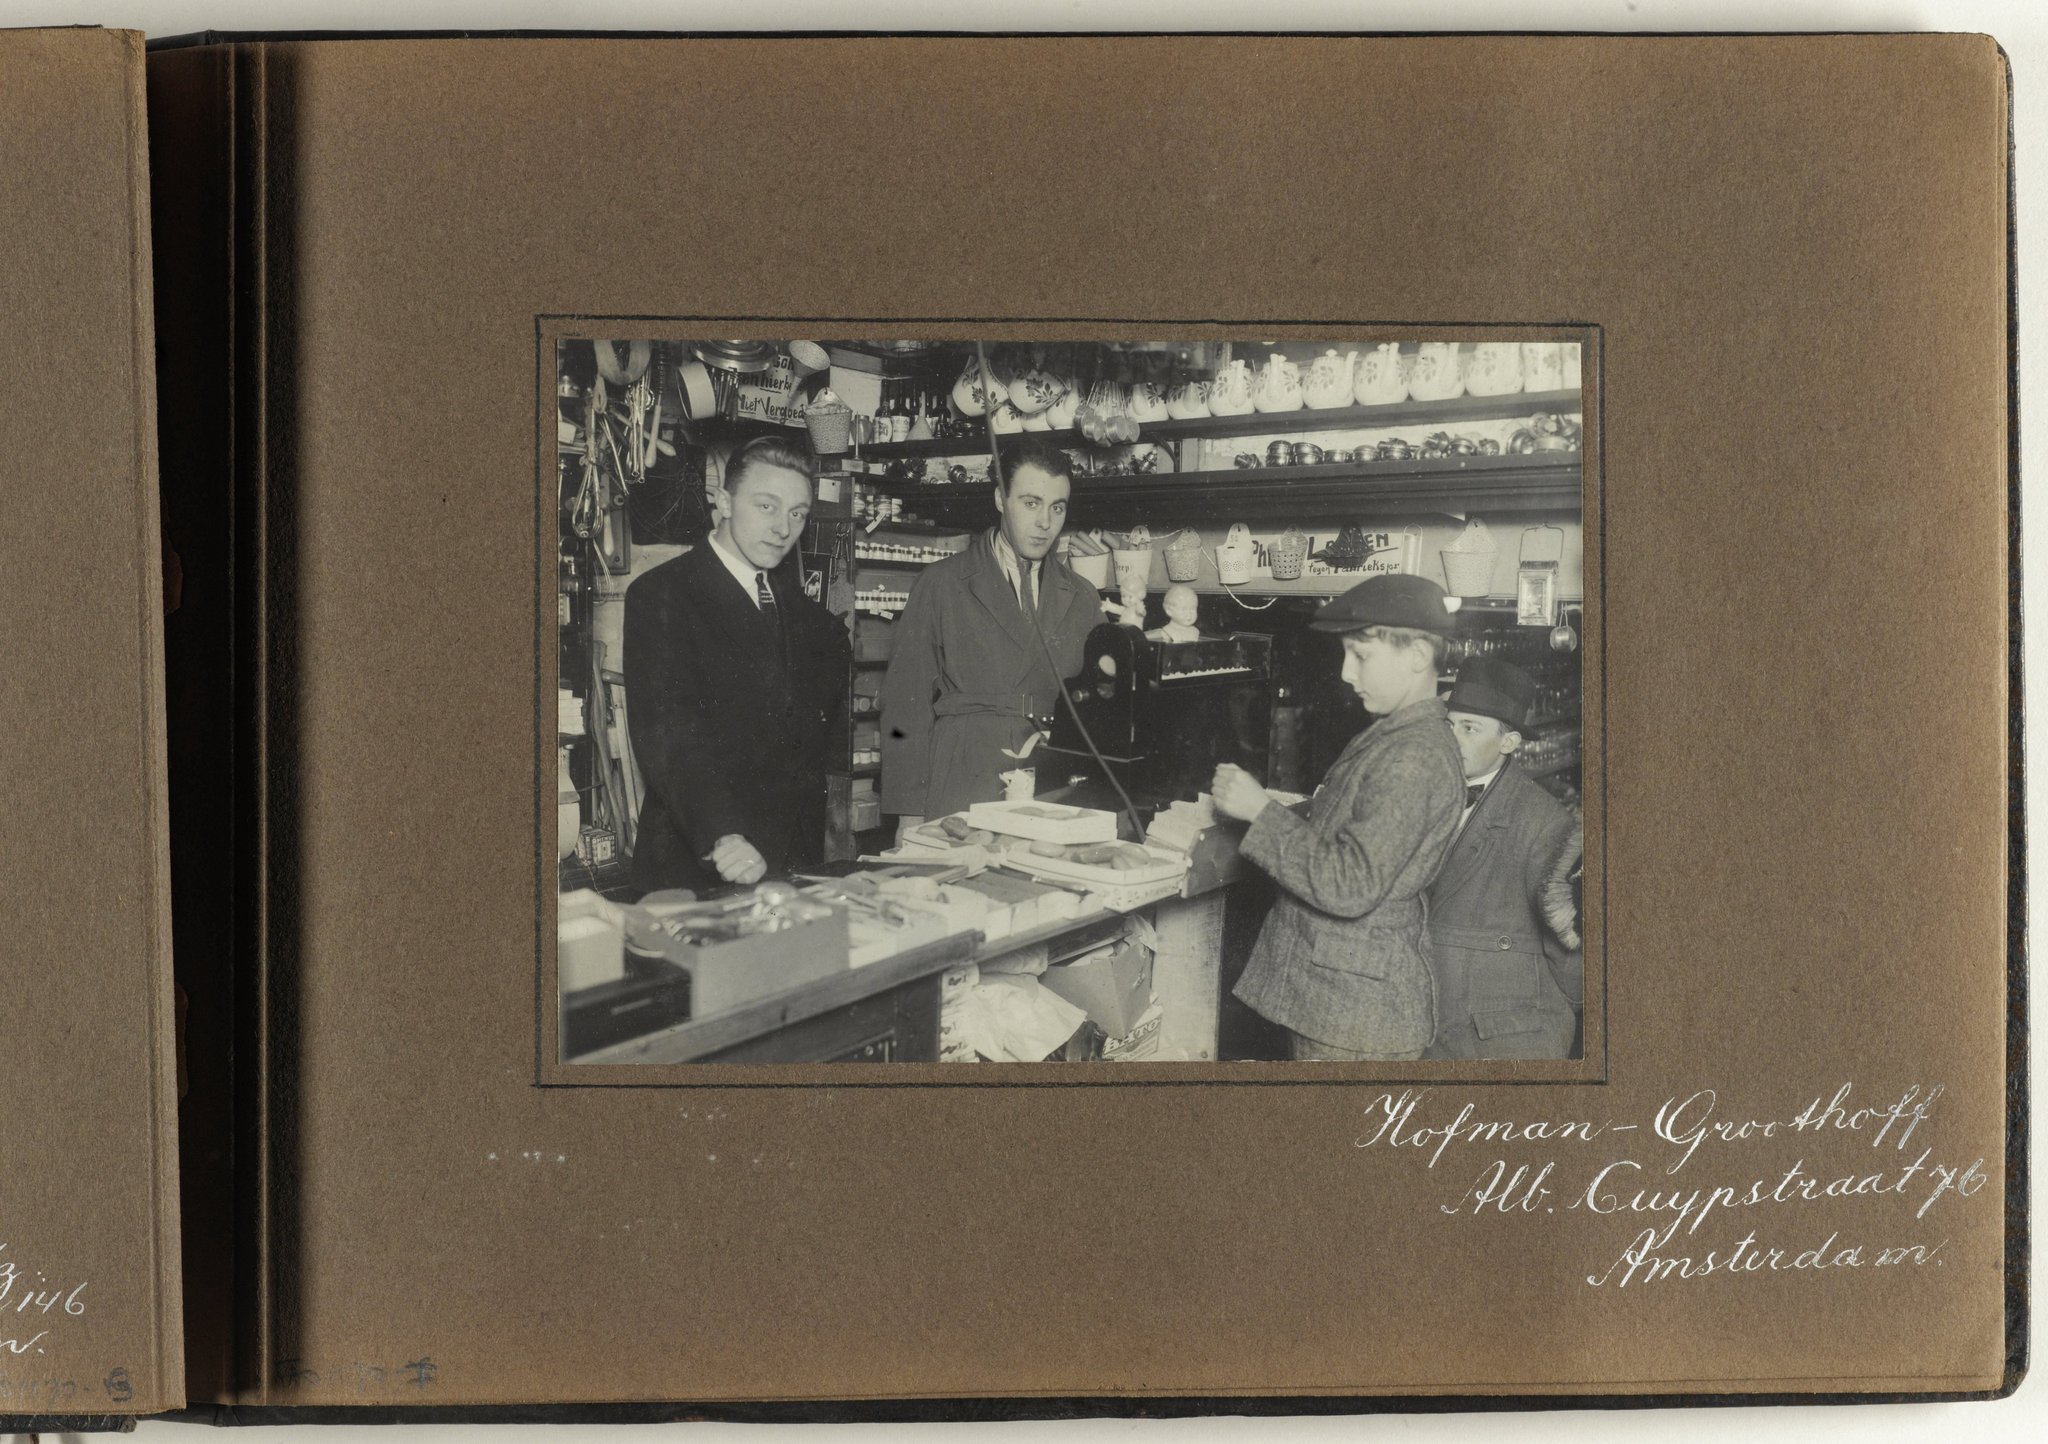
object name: photograph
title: Interieur van de winkel in huishoudelijke artikelen van Hofman–Groothoff, Albert Cuypstraat 76, Amsterdam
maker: Anonymous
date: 1925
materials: paper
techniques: gelatin silver print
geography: amsterdam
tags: counter ~ shop, amsterdam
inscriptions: annotation: ‘Hofman-Groothoff/ Alb. Cuypstraat 76/ Amsterdam’